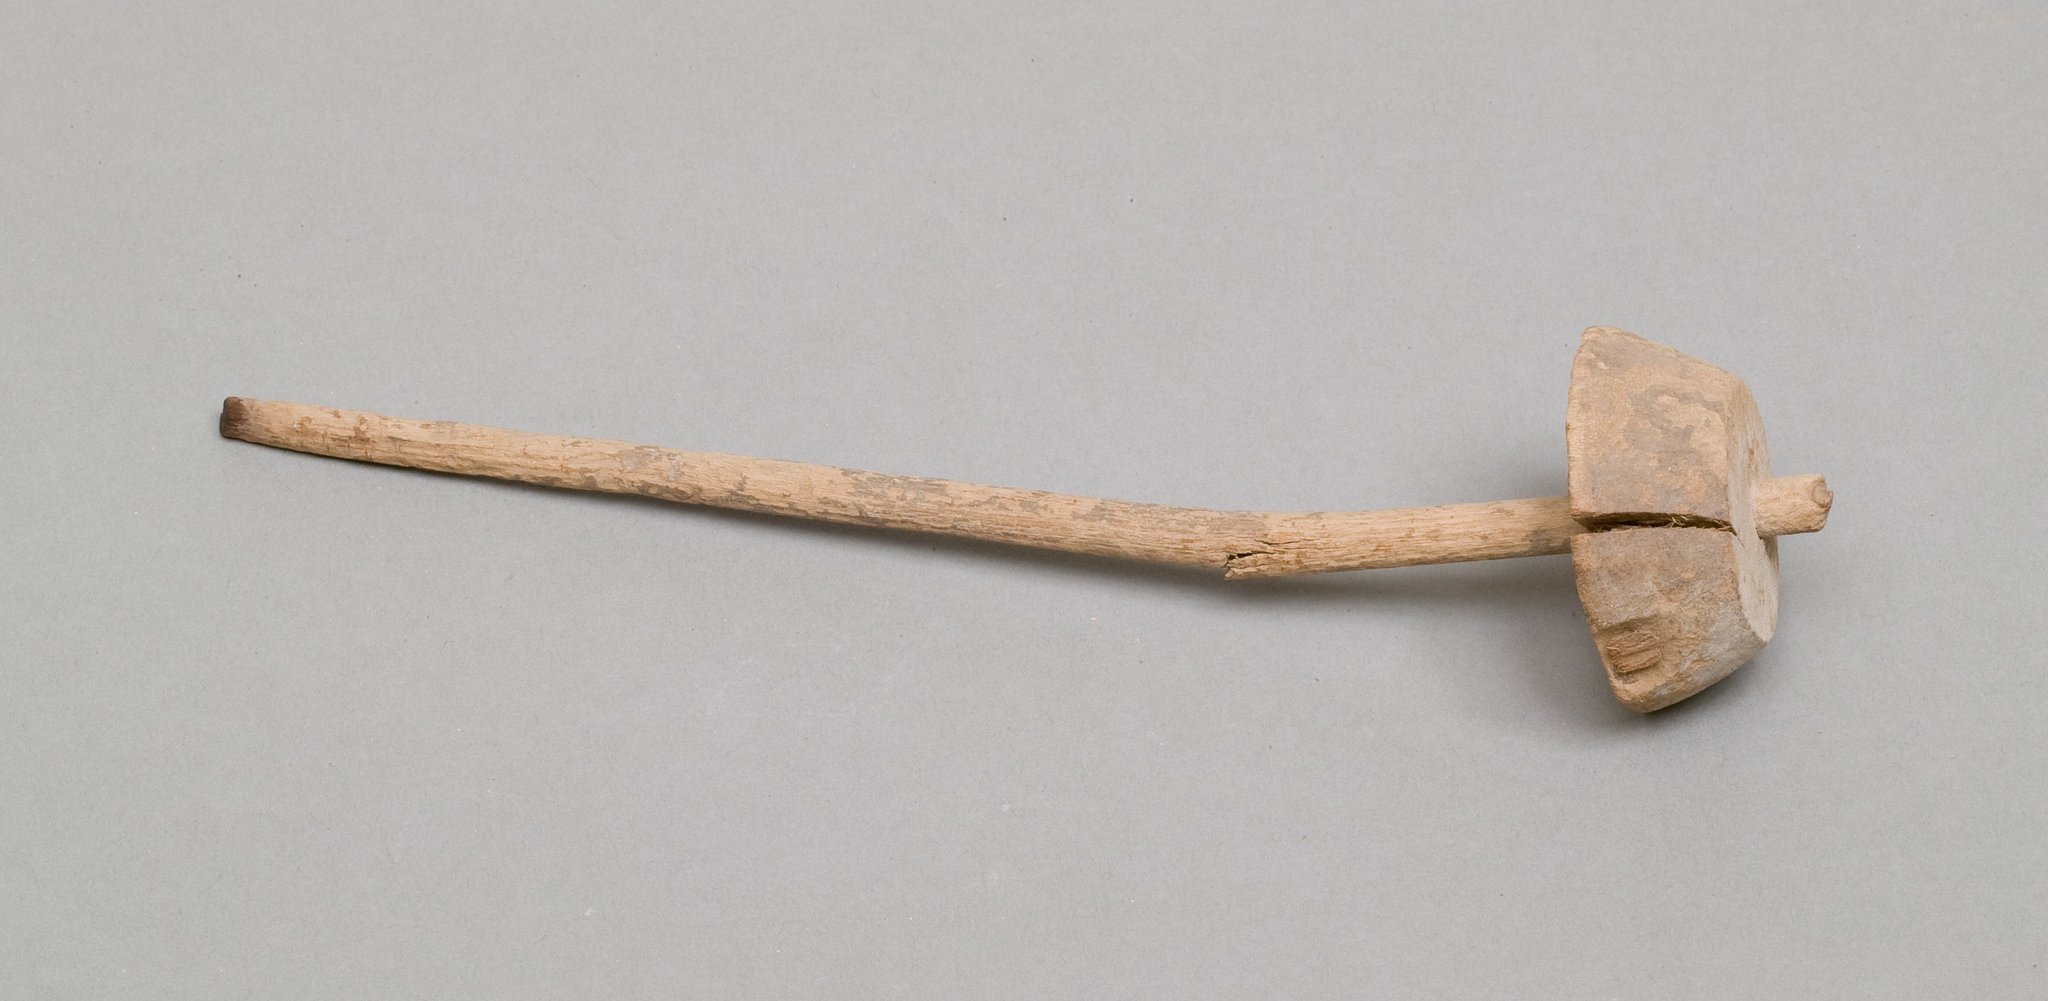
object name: spindle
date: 1295-1070 BCE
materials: wood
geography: egypt